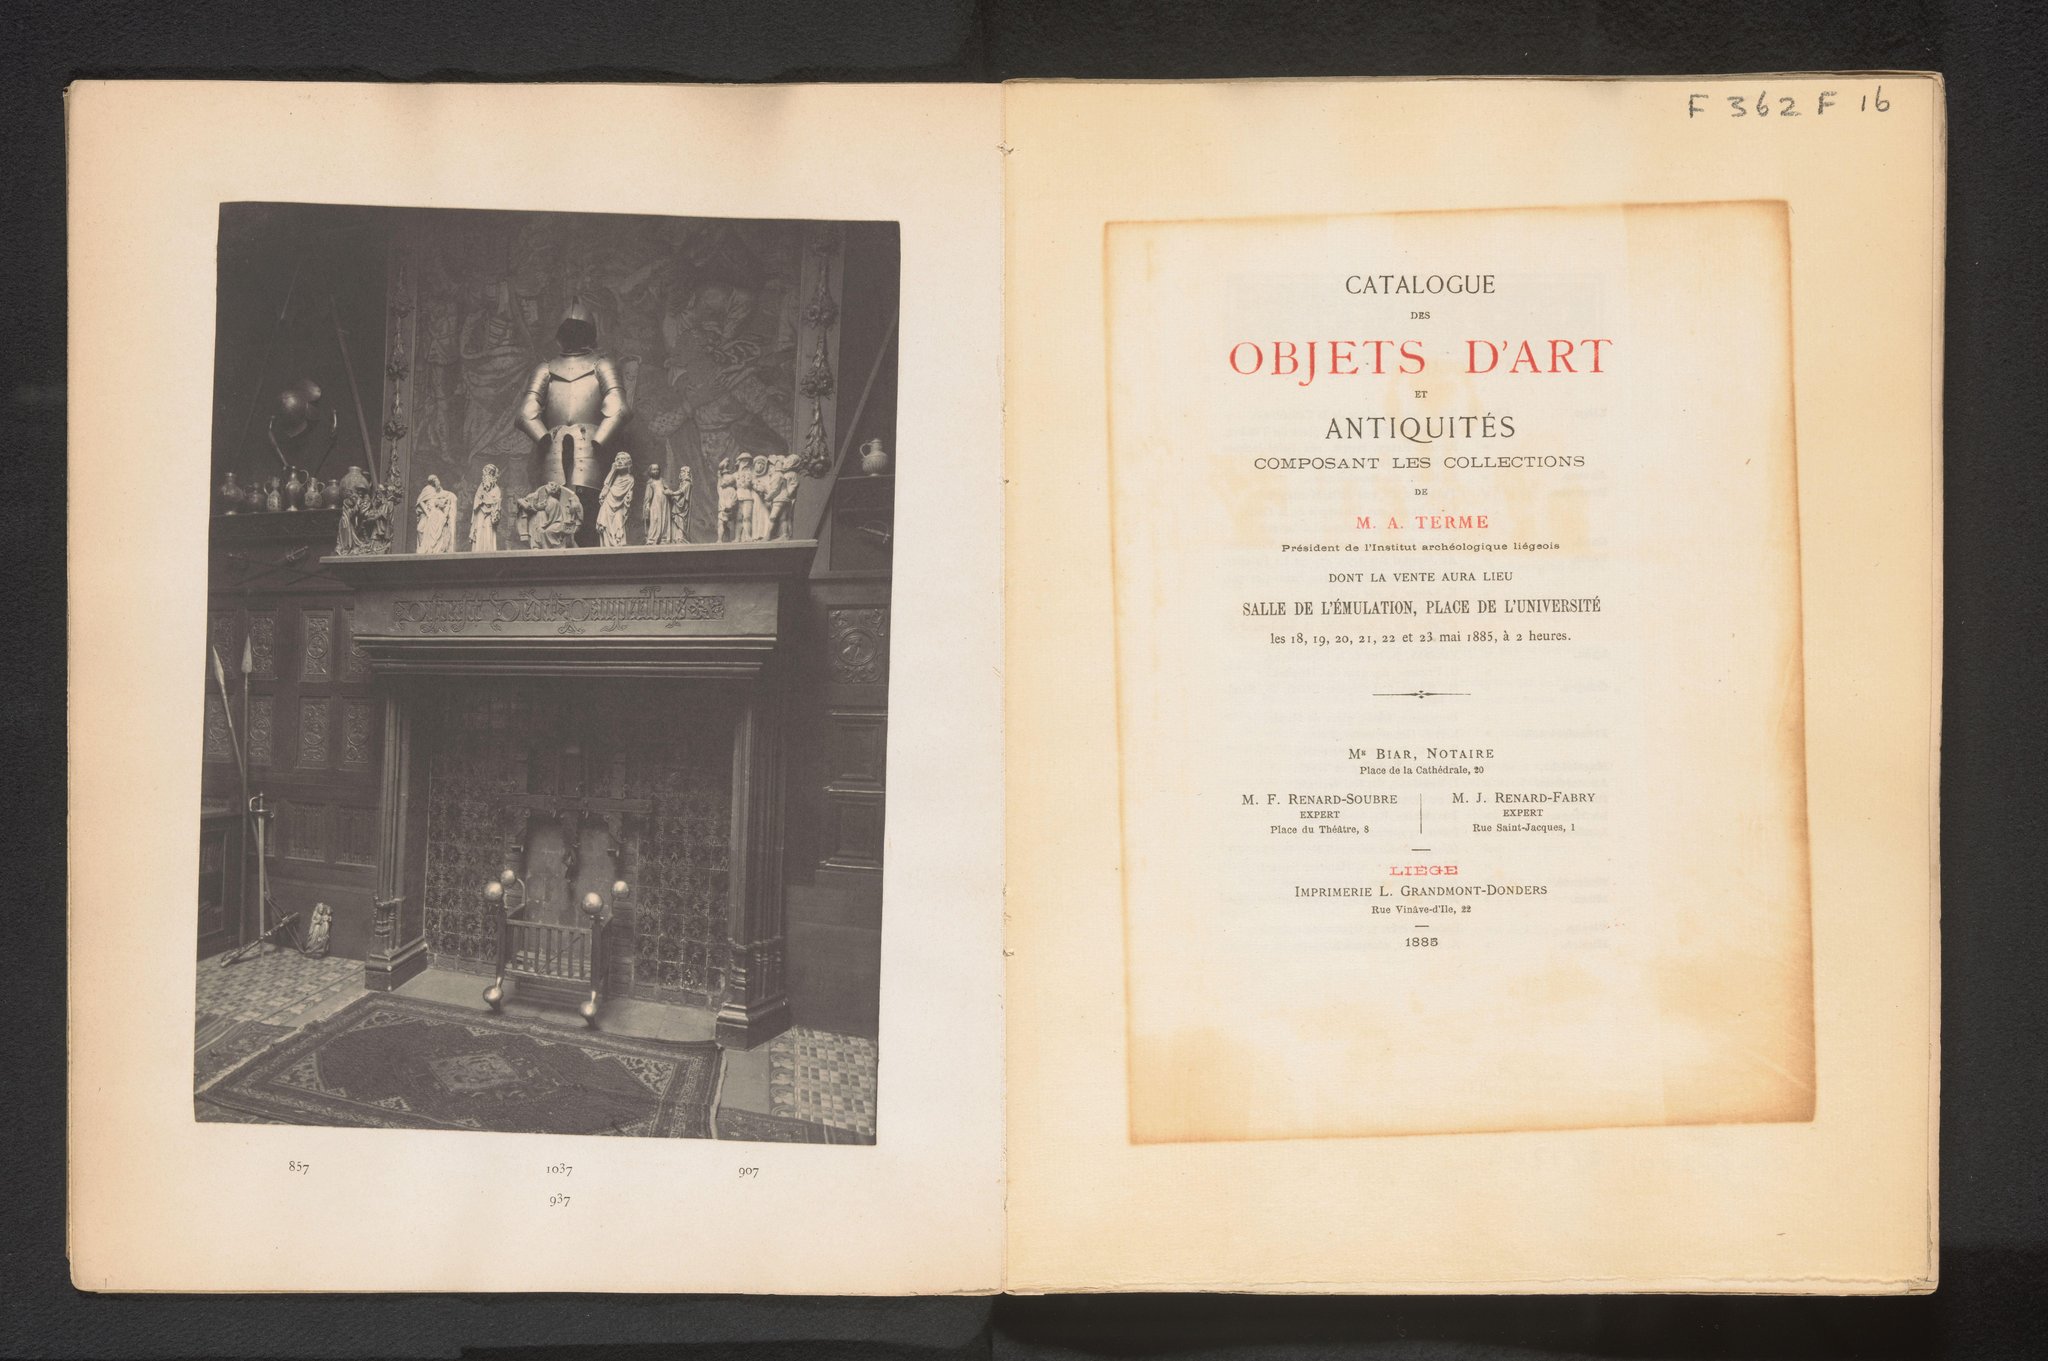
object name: book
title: Catalogue des objets d'art et antiquités composant les collections de M. A. Terme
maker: l. grandmont-donders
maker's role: publisher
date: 1885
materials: linen, paper, photographic support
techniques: platinum process, printing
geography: liège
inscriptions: annotation: ‘exemplaire, no. 3/ J. Renard-Fabry/ expert’, annotation: ‘3000/ [...]’, date: ‘MAY 1992’